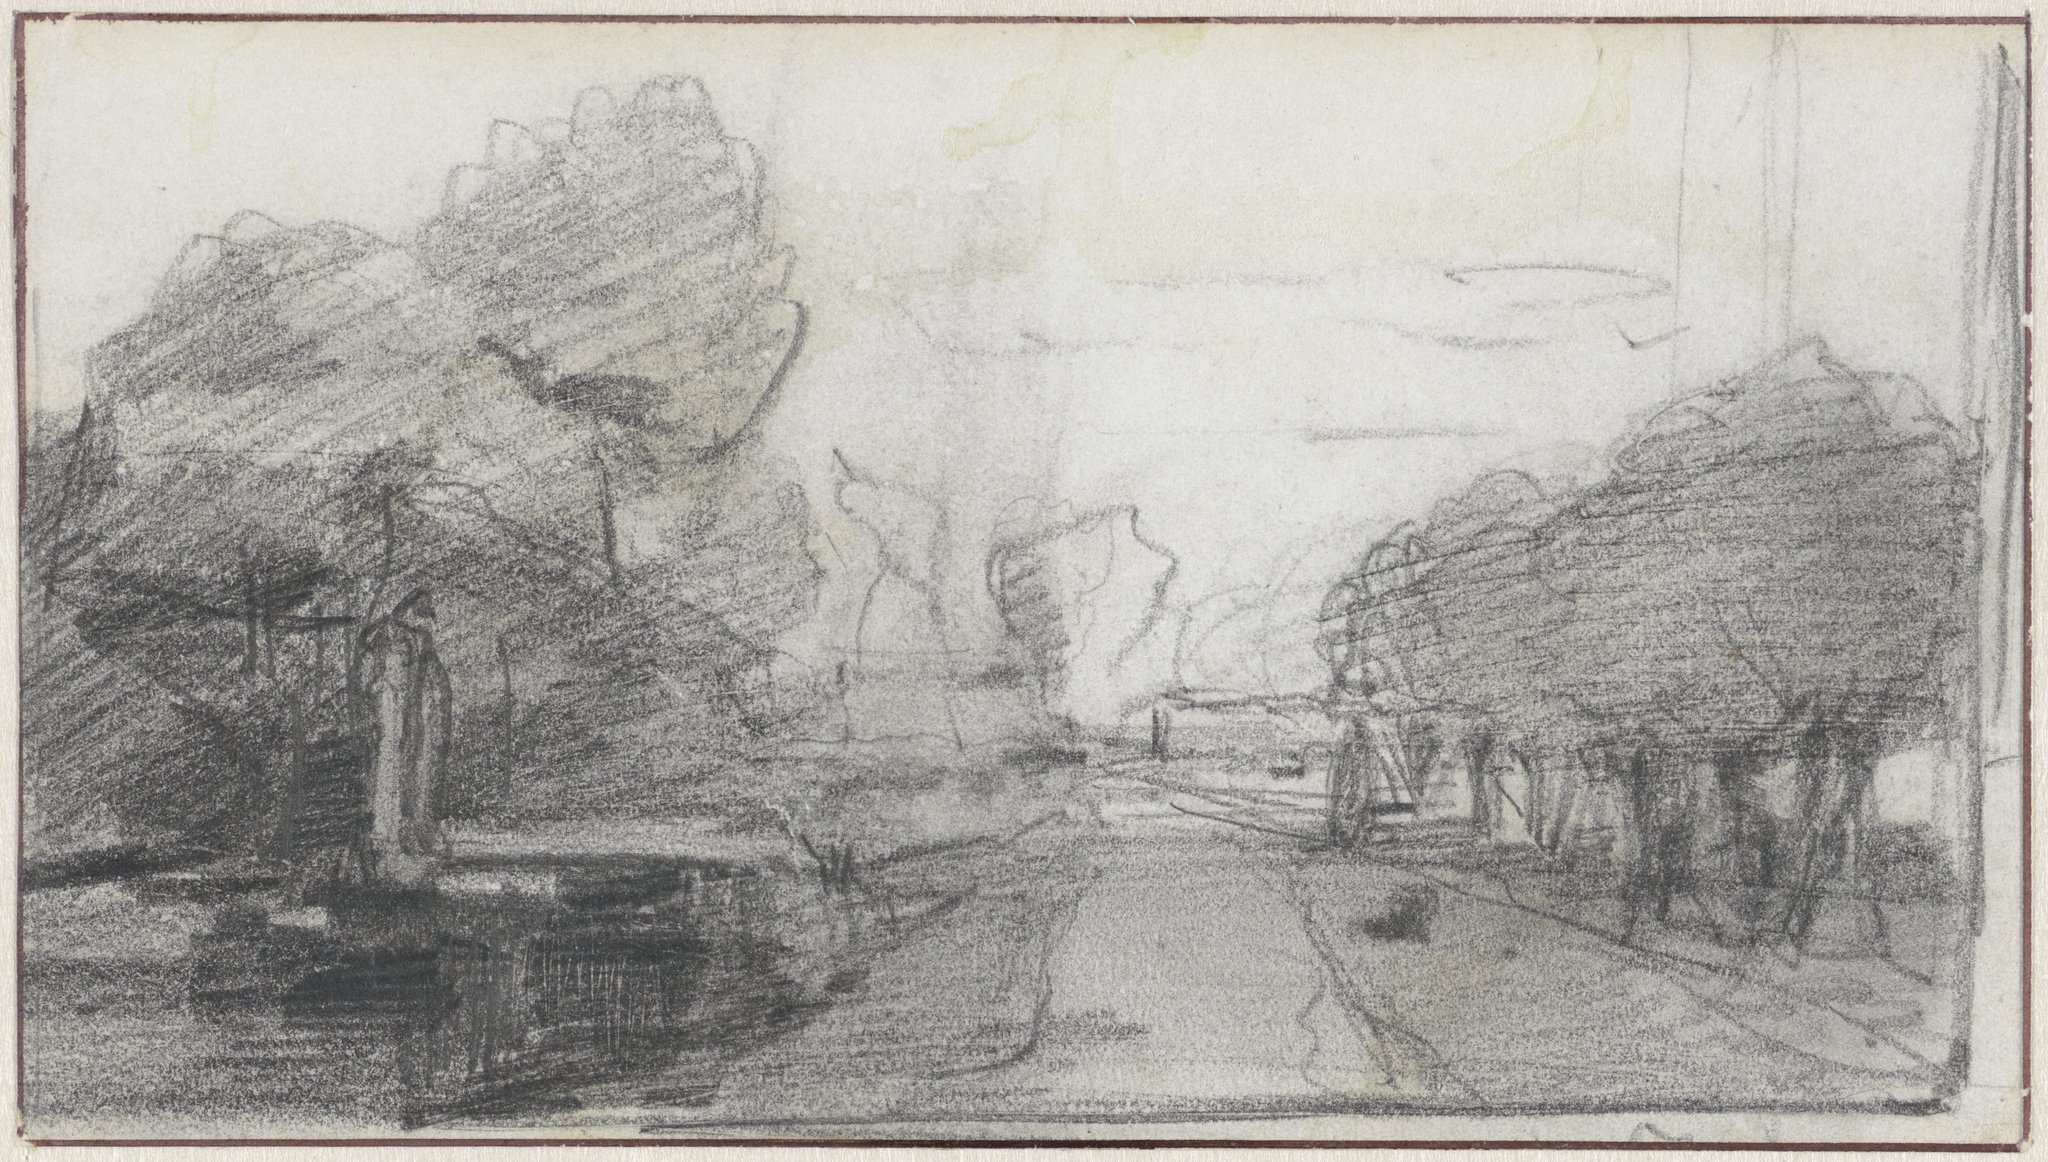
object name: drawing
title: Gezicht op een laan met aan weerszijden een bomenrij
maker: willem roelofs (i)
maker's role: draughtsman, painter, print maker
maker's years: 1822-1897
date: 1832-1897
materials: paper, pencil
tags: trees